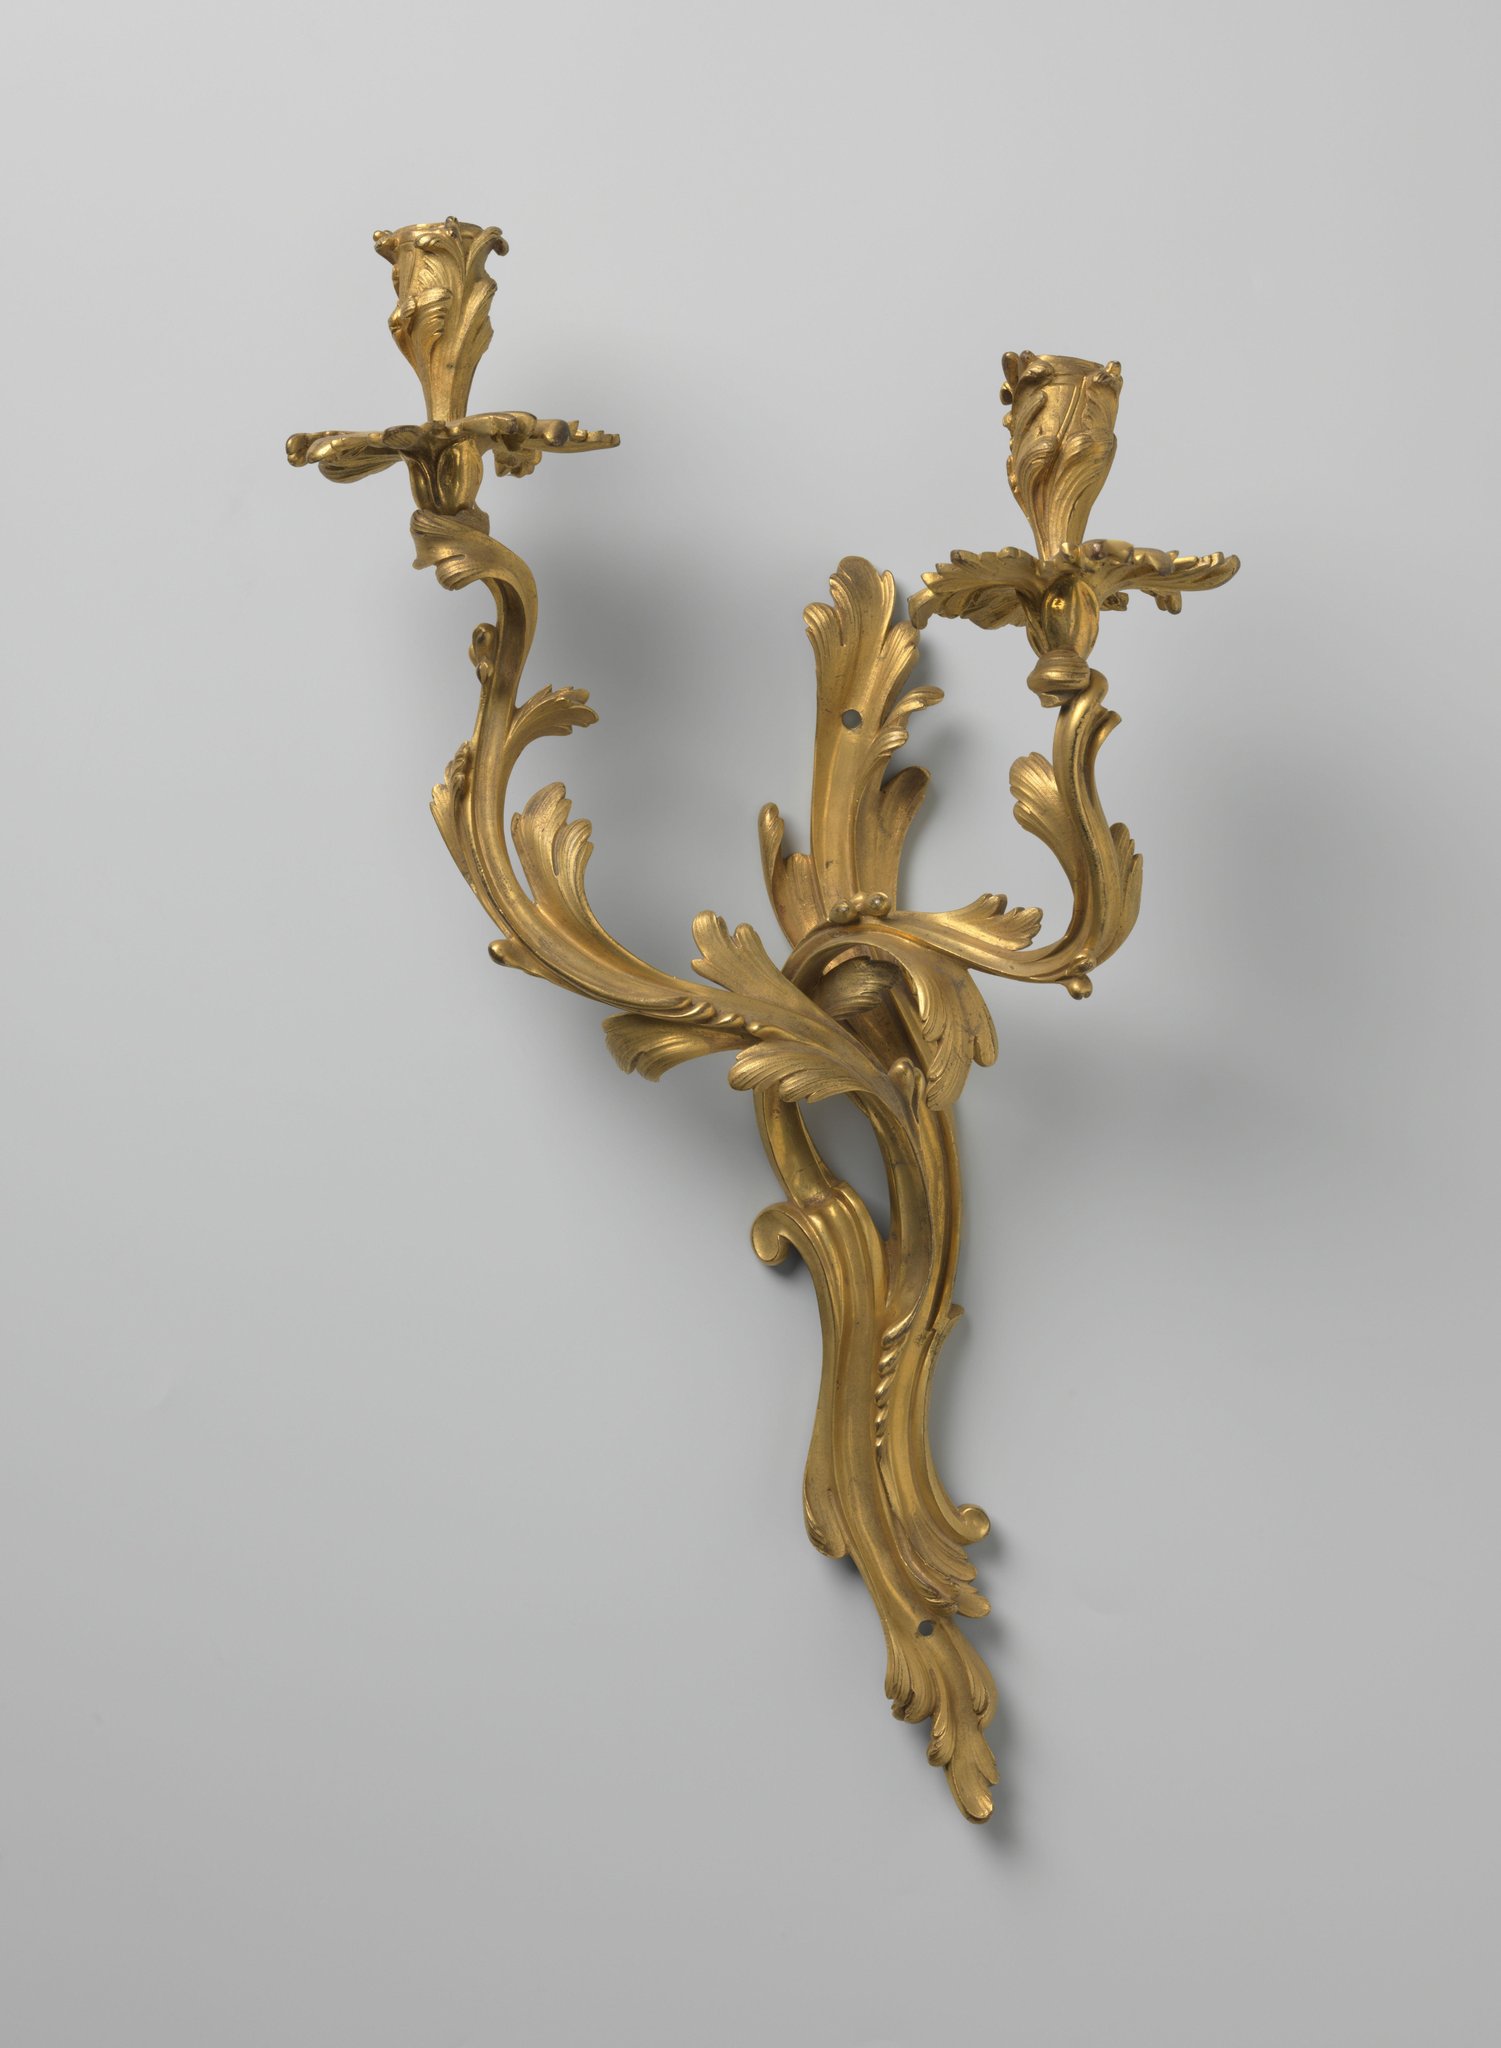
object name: furniture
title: Wandarm van gepolijst koper waarvan de onderdelen zijn opgebouwd uit bladvormen en bladvoluten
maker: Anonymous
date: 1740-1760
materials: copper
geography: france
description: Wandarm van gepolijst koper. De stam is opgebouwd uit bladvoluten, waarvan er twee elkaar bovenaan kruisen en doorlopen in de armen. De vethouders zijn bladvormig en de kaarsenhouders zijn eveneens opgebouwd uit bladvoluten. Zie tevens: BK-14301-b.